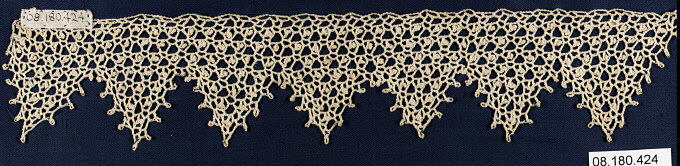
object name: fragment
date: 1801-1900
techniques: crochet